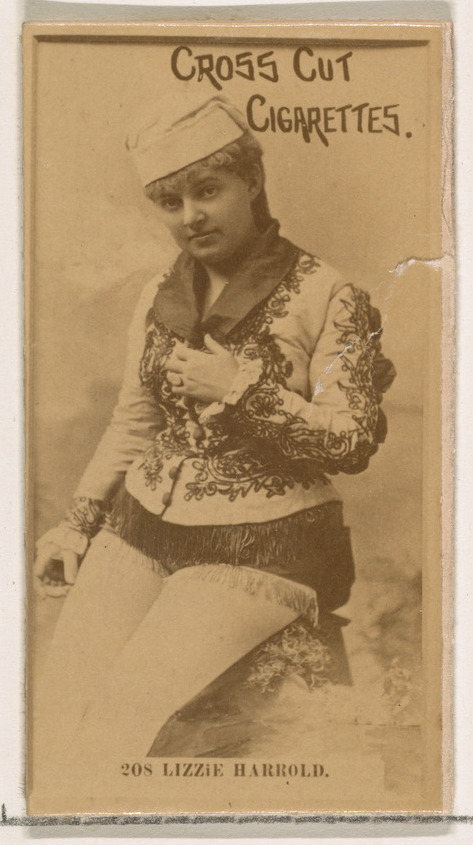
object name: print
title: Card Number 208, Lizzie Harrold, from the Actors and Actresses series (N145-2) issued by Duke Sons & Co. to promote Cross Cut Cigarettes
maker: w. duke, sons & co.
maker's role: publisher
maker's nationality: american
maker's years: 1870-1920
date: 1880-1889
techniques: albumen silver print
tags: portraits,women,actresses